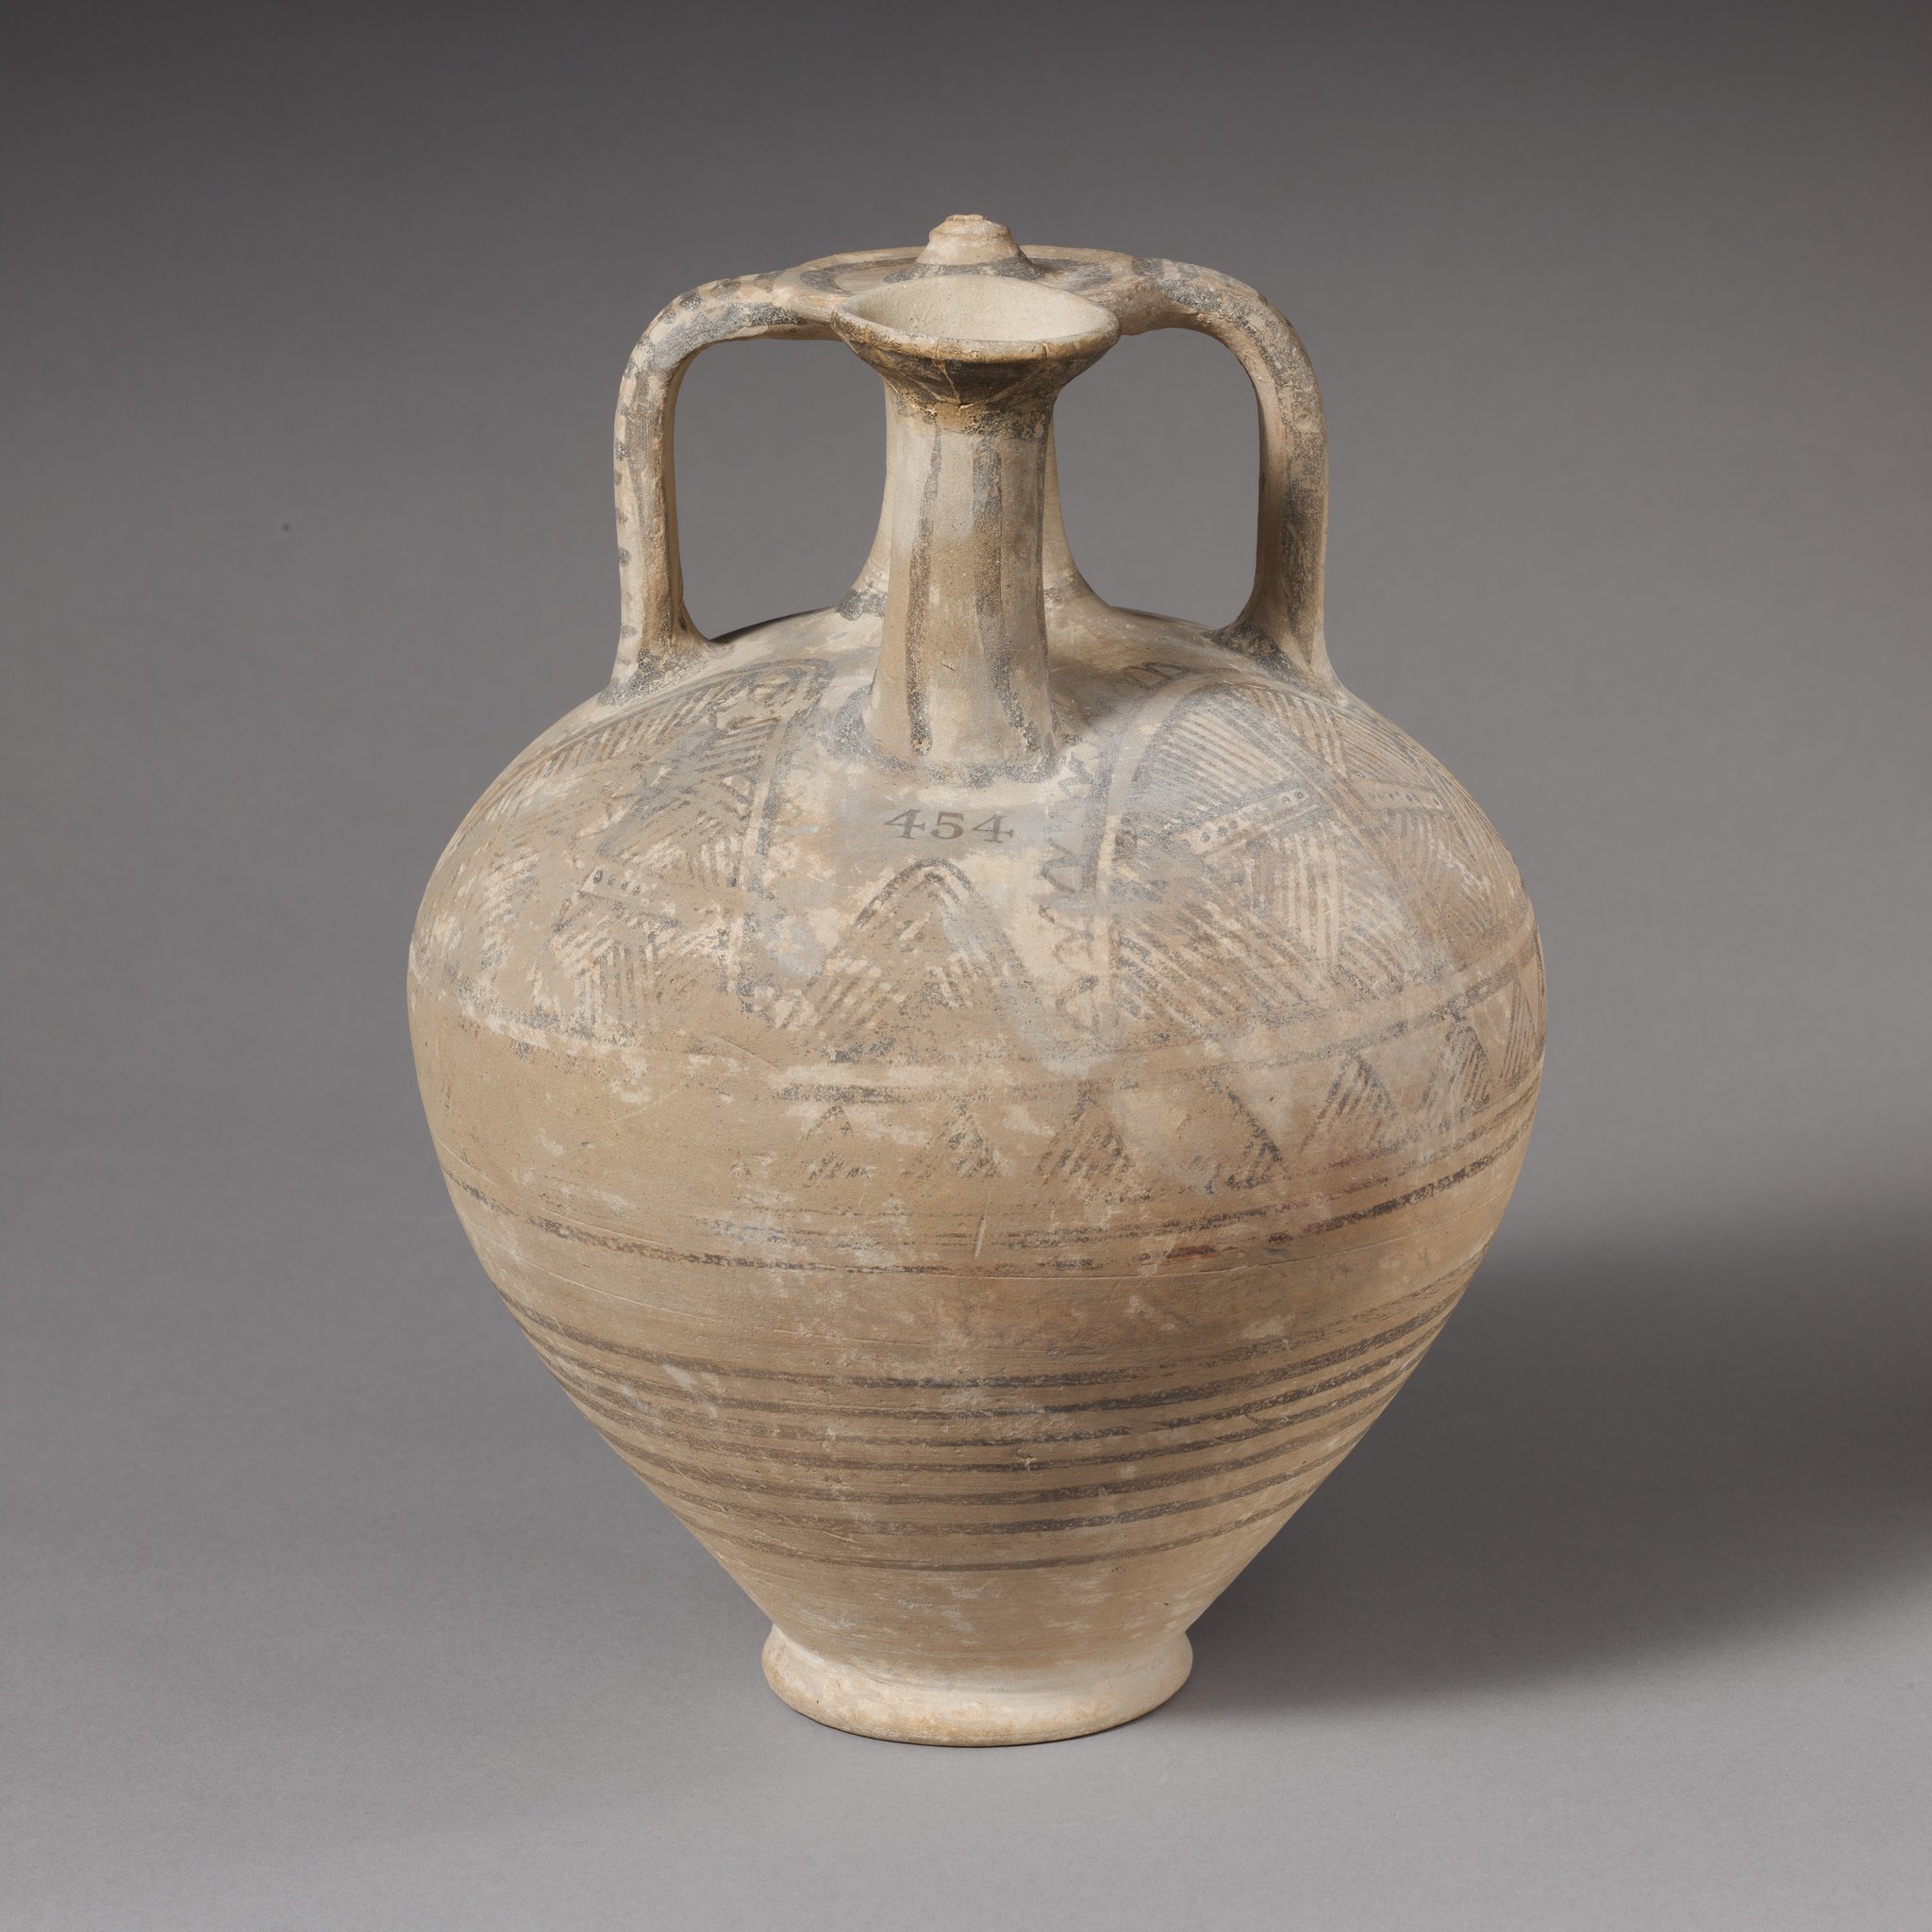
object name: stirrup jar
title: Terracotta stirrup jar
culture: cypriot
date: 1200-1050 BCE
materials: terracotta